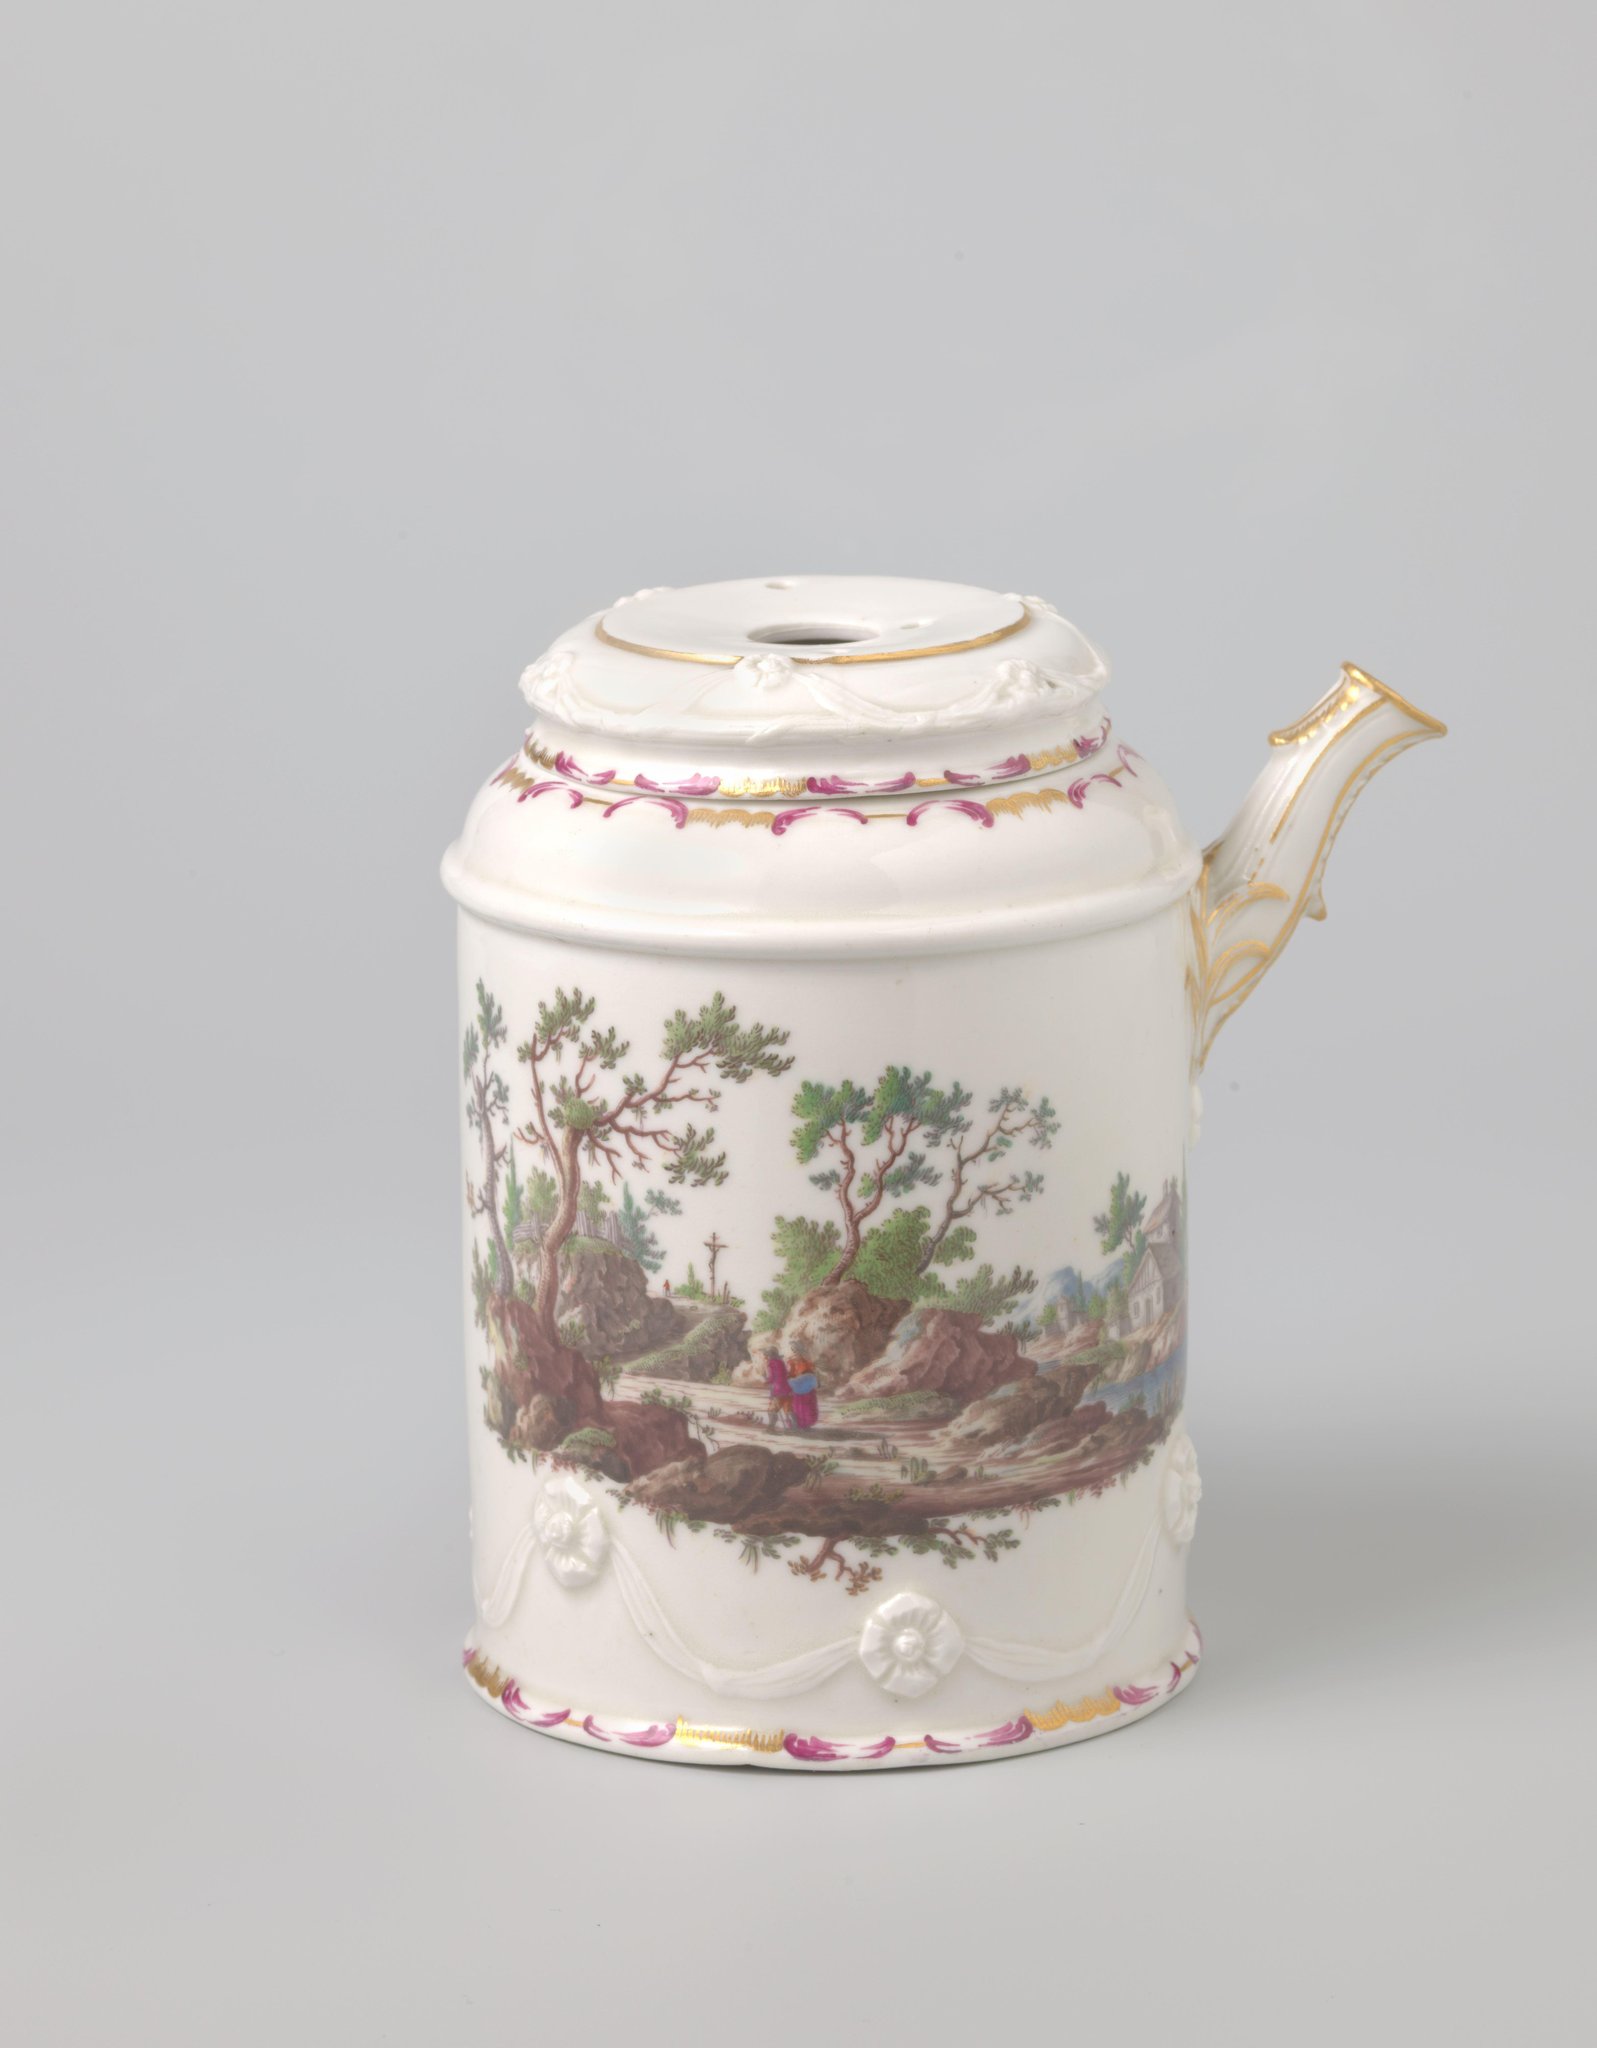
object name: chocolate pot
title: Cover of a chocolate pot with a landscape and garlands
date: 1770-1775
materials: glaze, gold, paint, porcelain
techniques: firing, forming, gilding, relief, vitrification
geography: ludwigsburg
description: Deksel van een kan of pot (chocoladekan) van porselein met een gat in het midden, waaromheen drie kleinere gaten. Beschilderd op het glazuur in emailkleuren en goud. Versierd met een gouden lijn, een band van rocailles en in reliëf een bloemslinger.